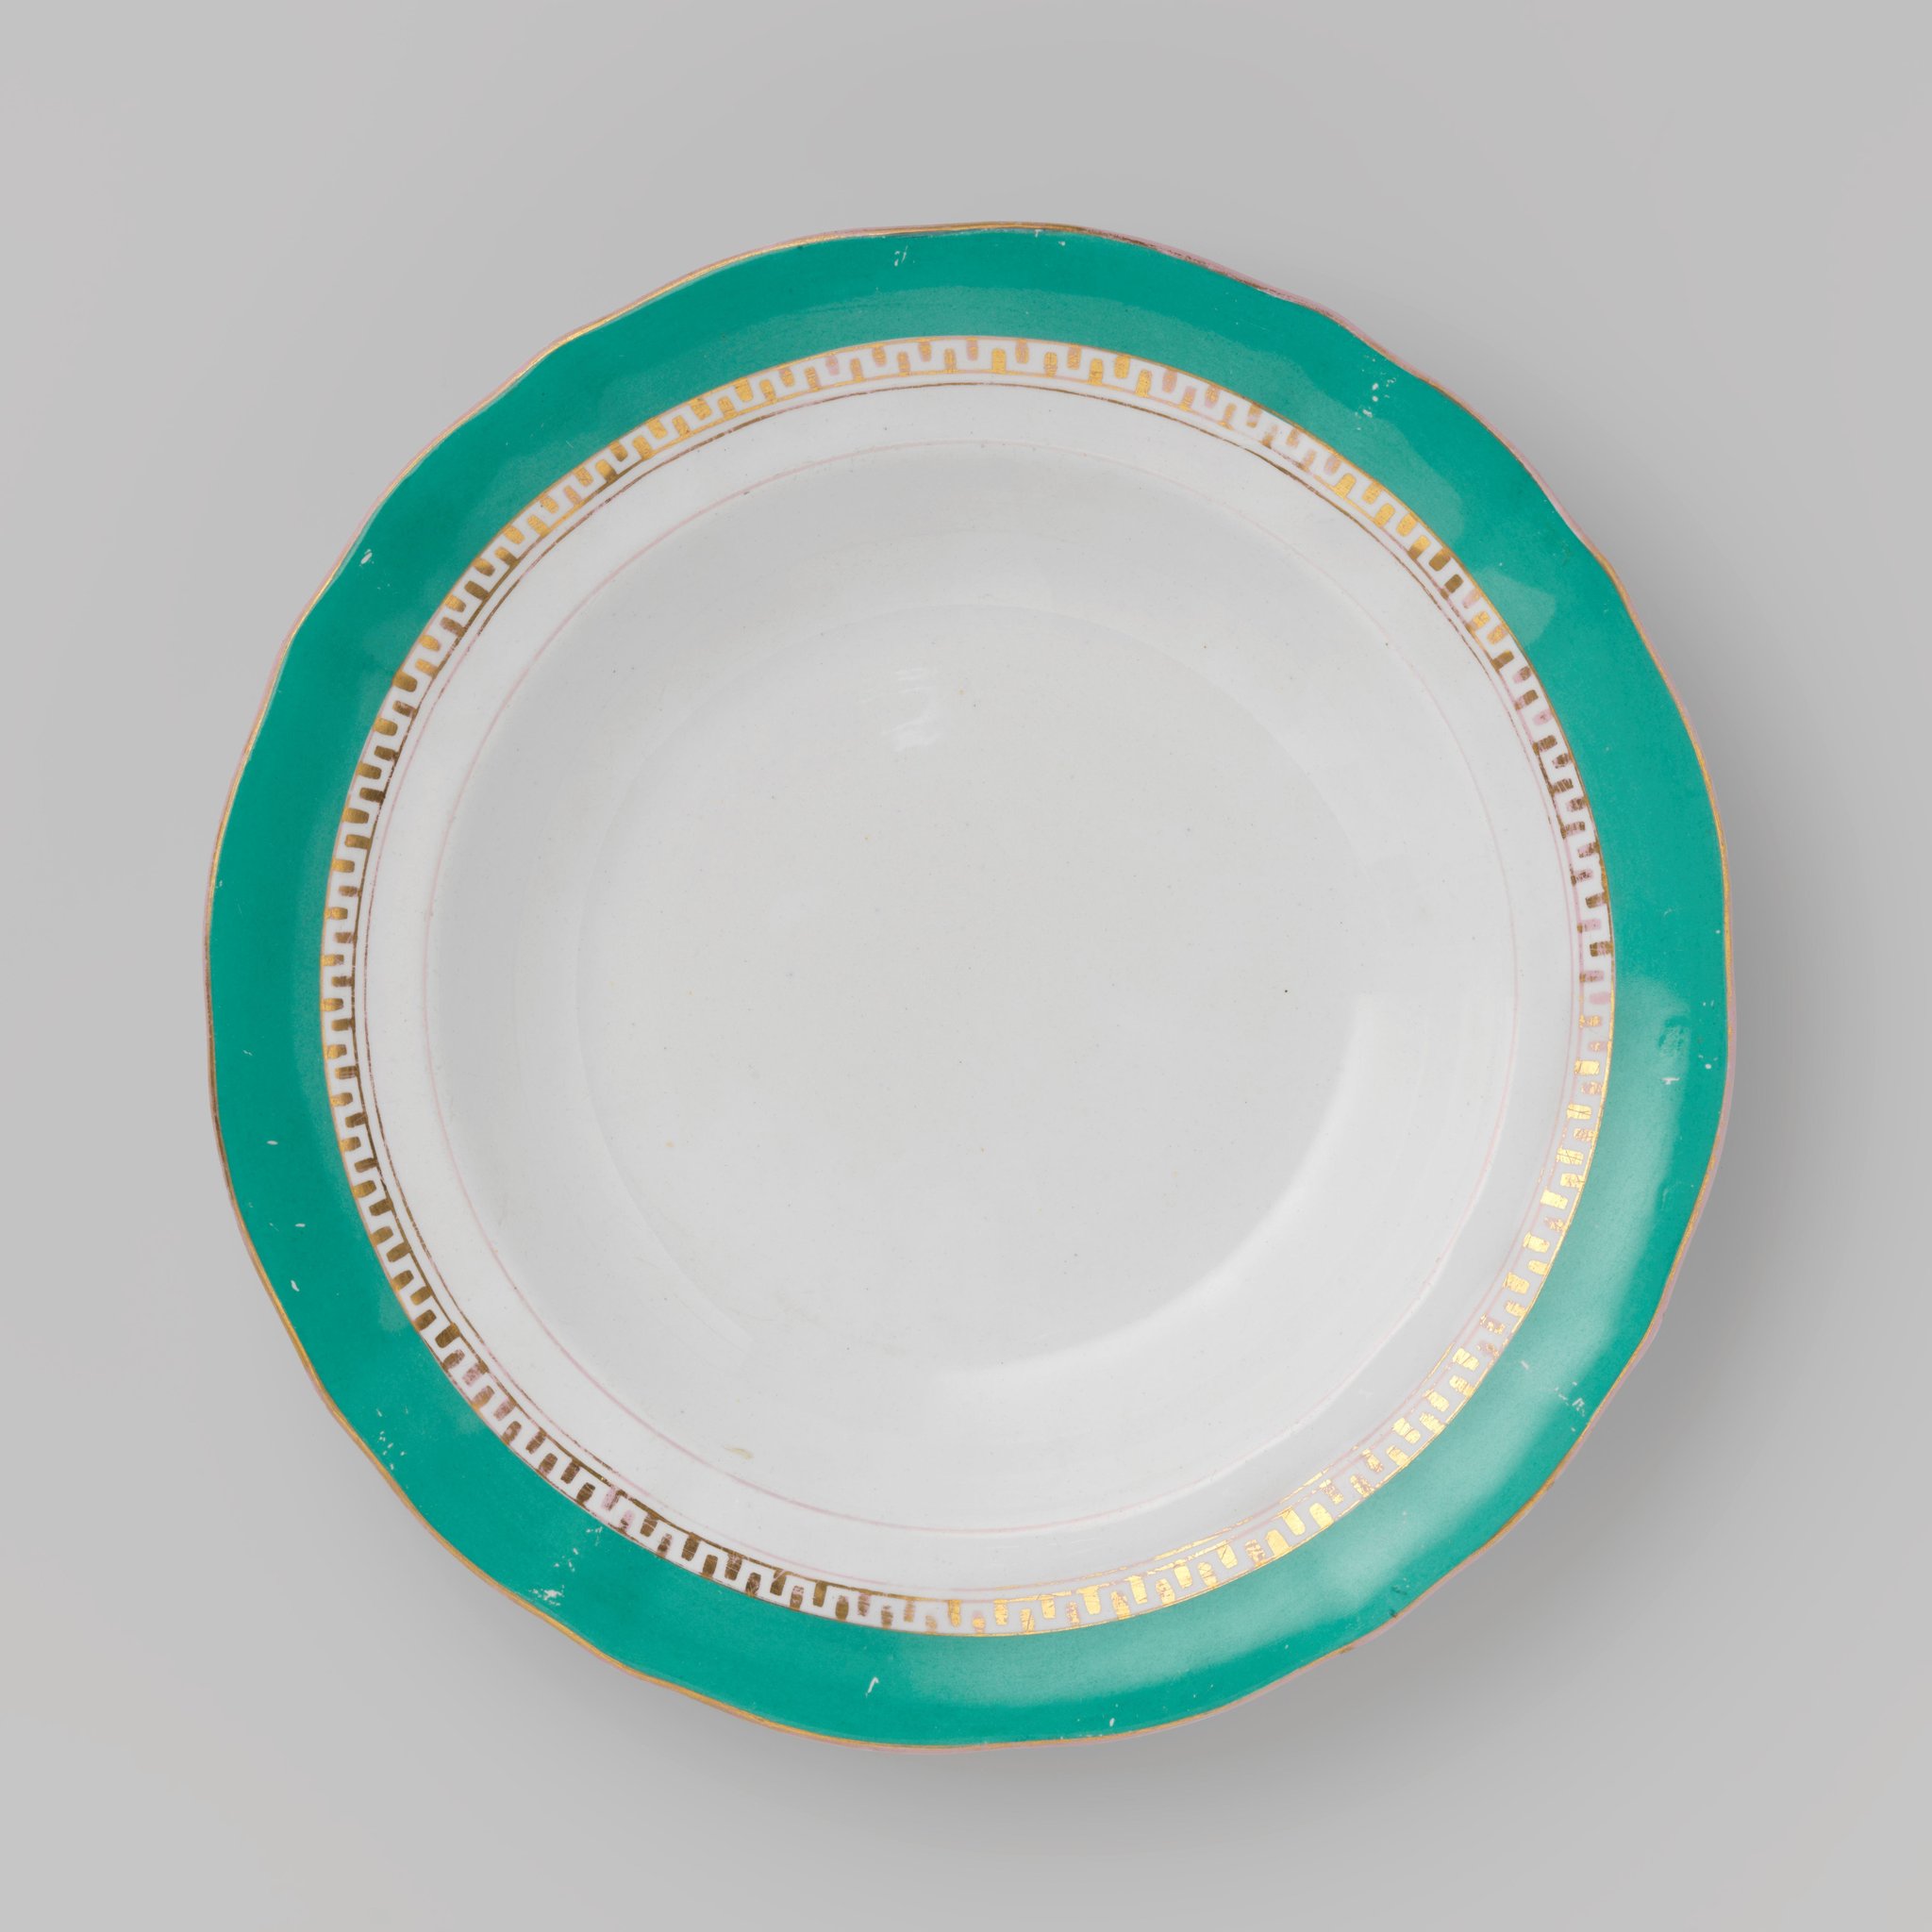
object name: plate dish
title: Bord met groene rand en gouden Griekse band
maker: petrus regout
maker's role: plateelbakker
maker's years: 1801-1879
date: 1865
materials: earthenware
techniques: transfer decoration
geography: maastricht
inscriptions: check stamp: ‘P. REGOUT // MAASTRICHT // 8X’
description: Bord van aardewerk, geschulpt, met groene rand en gouden Griekse band.